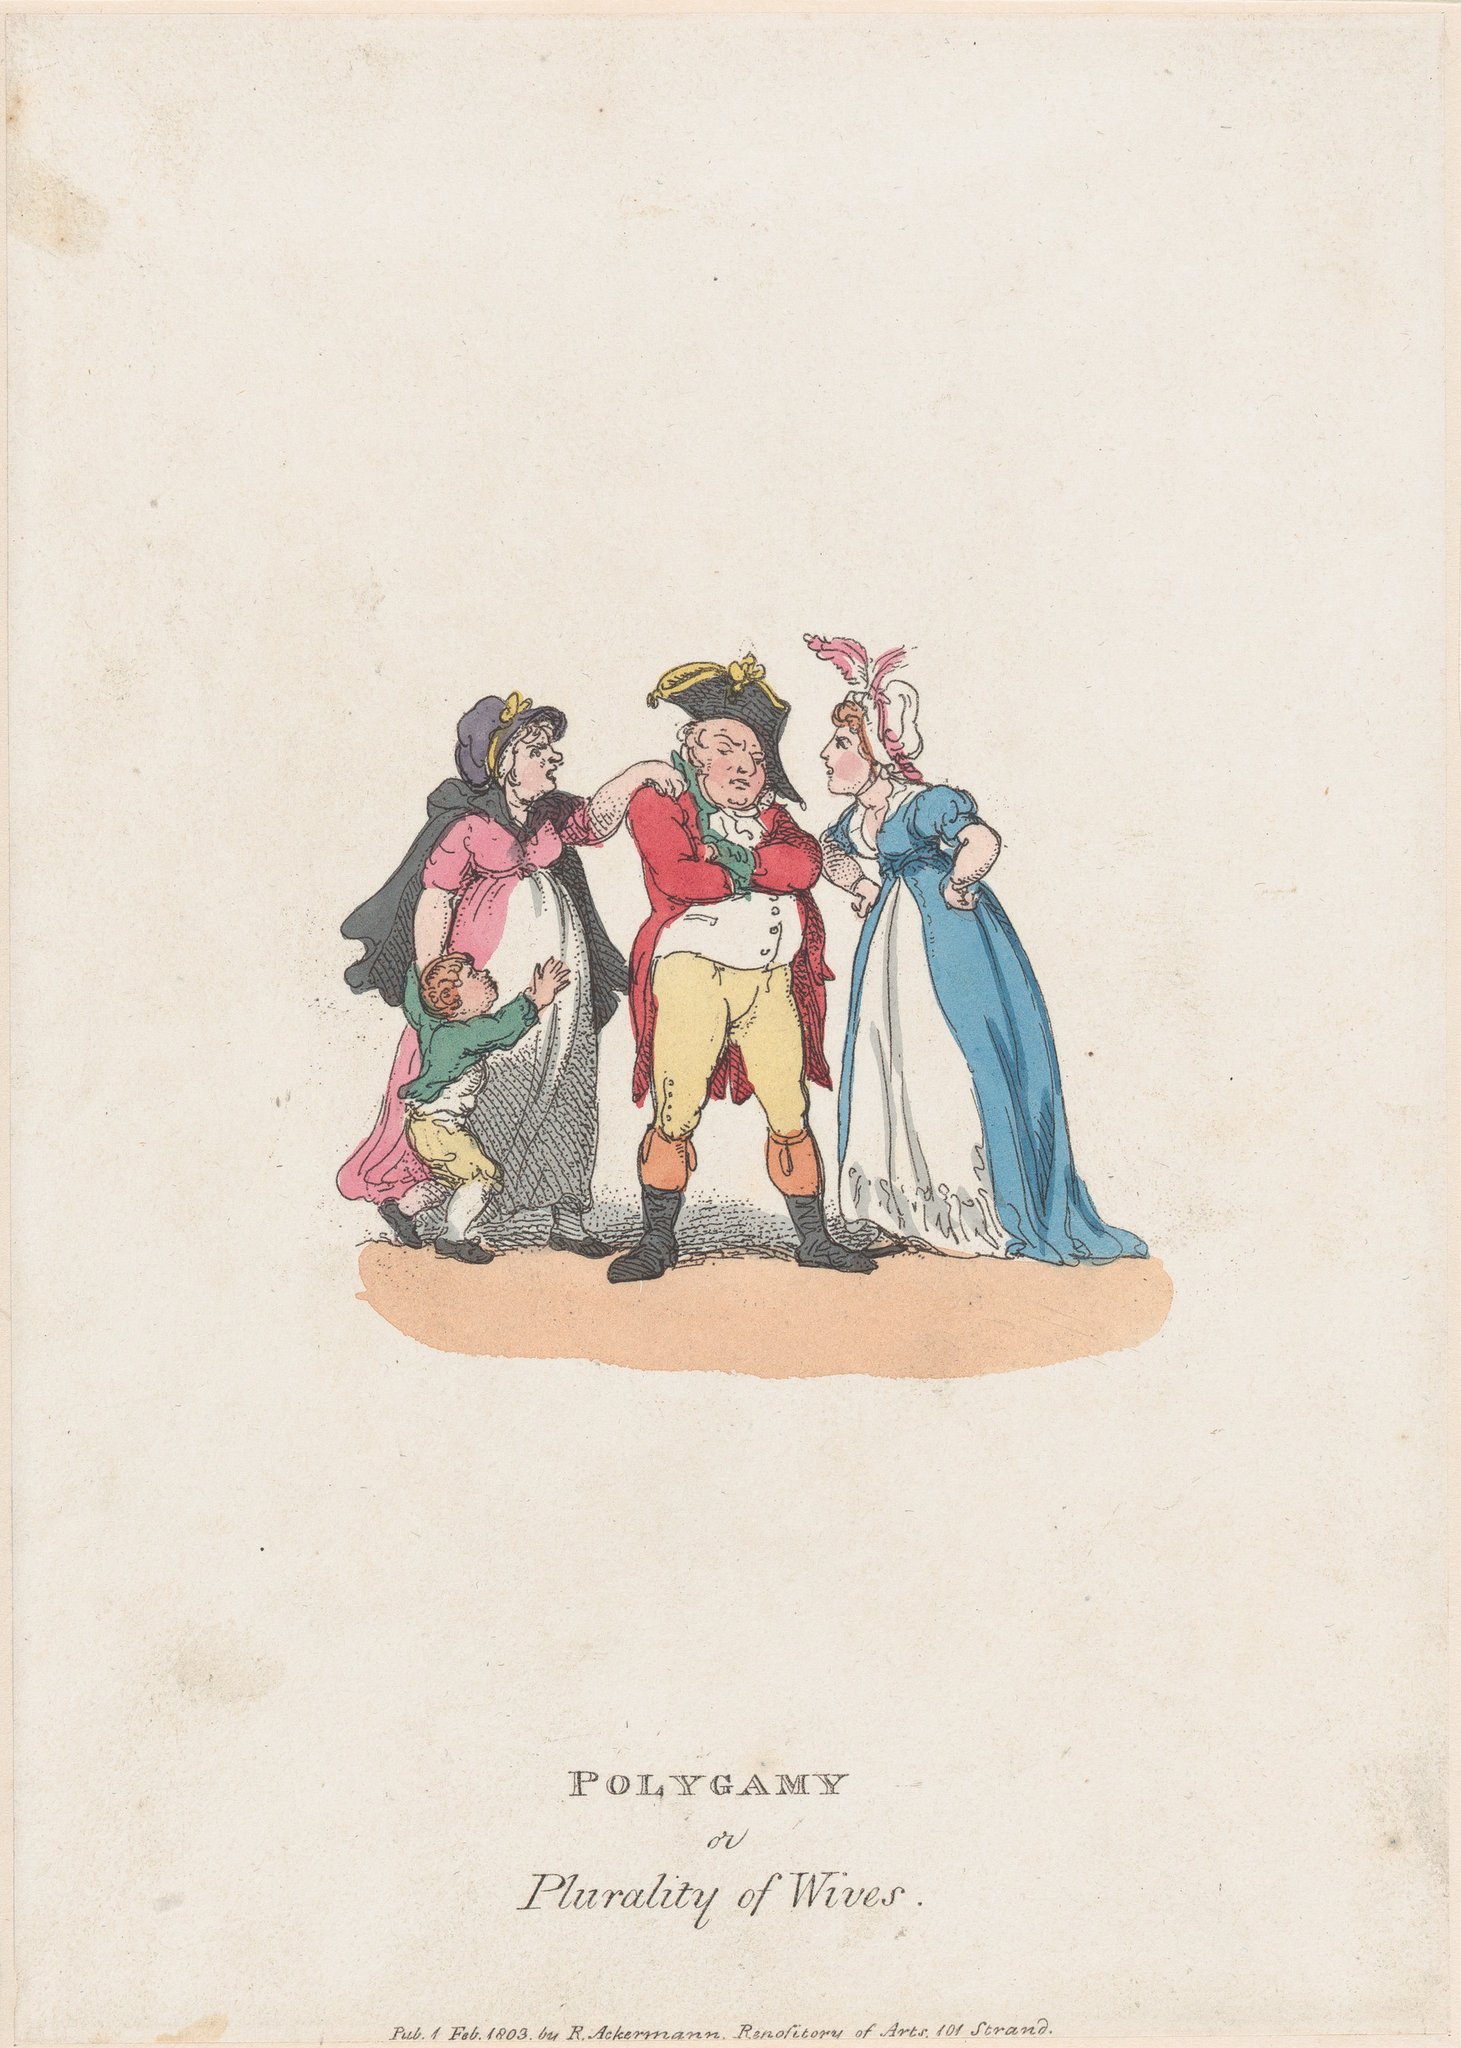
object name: print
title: Polygamy, or Plurality of Wives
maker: thomas rowlandson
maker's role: artist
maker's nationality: british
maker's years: 1757-1827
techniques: etching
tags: satire,boys,men,women